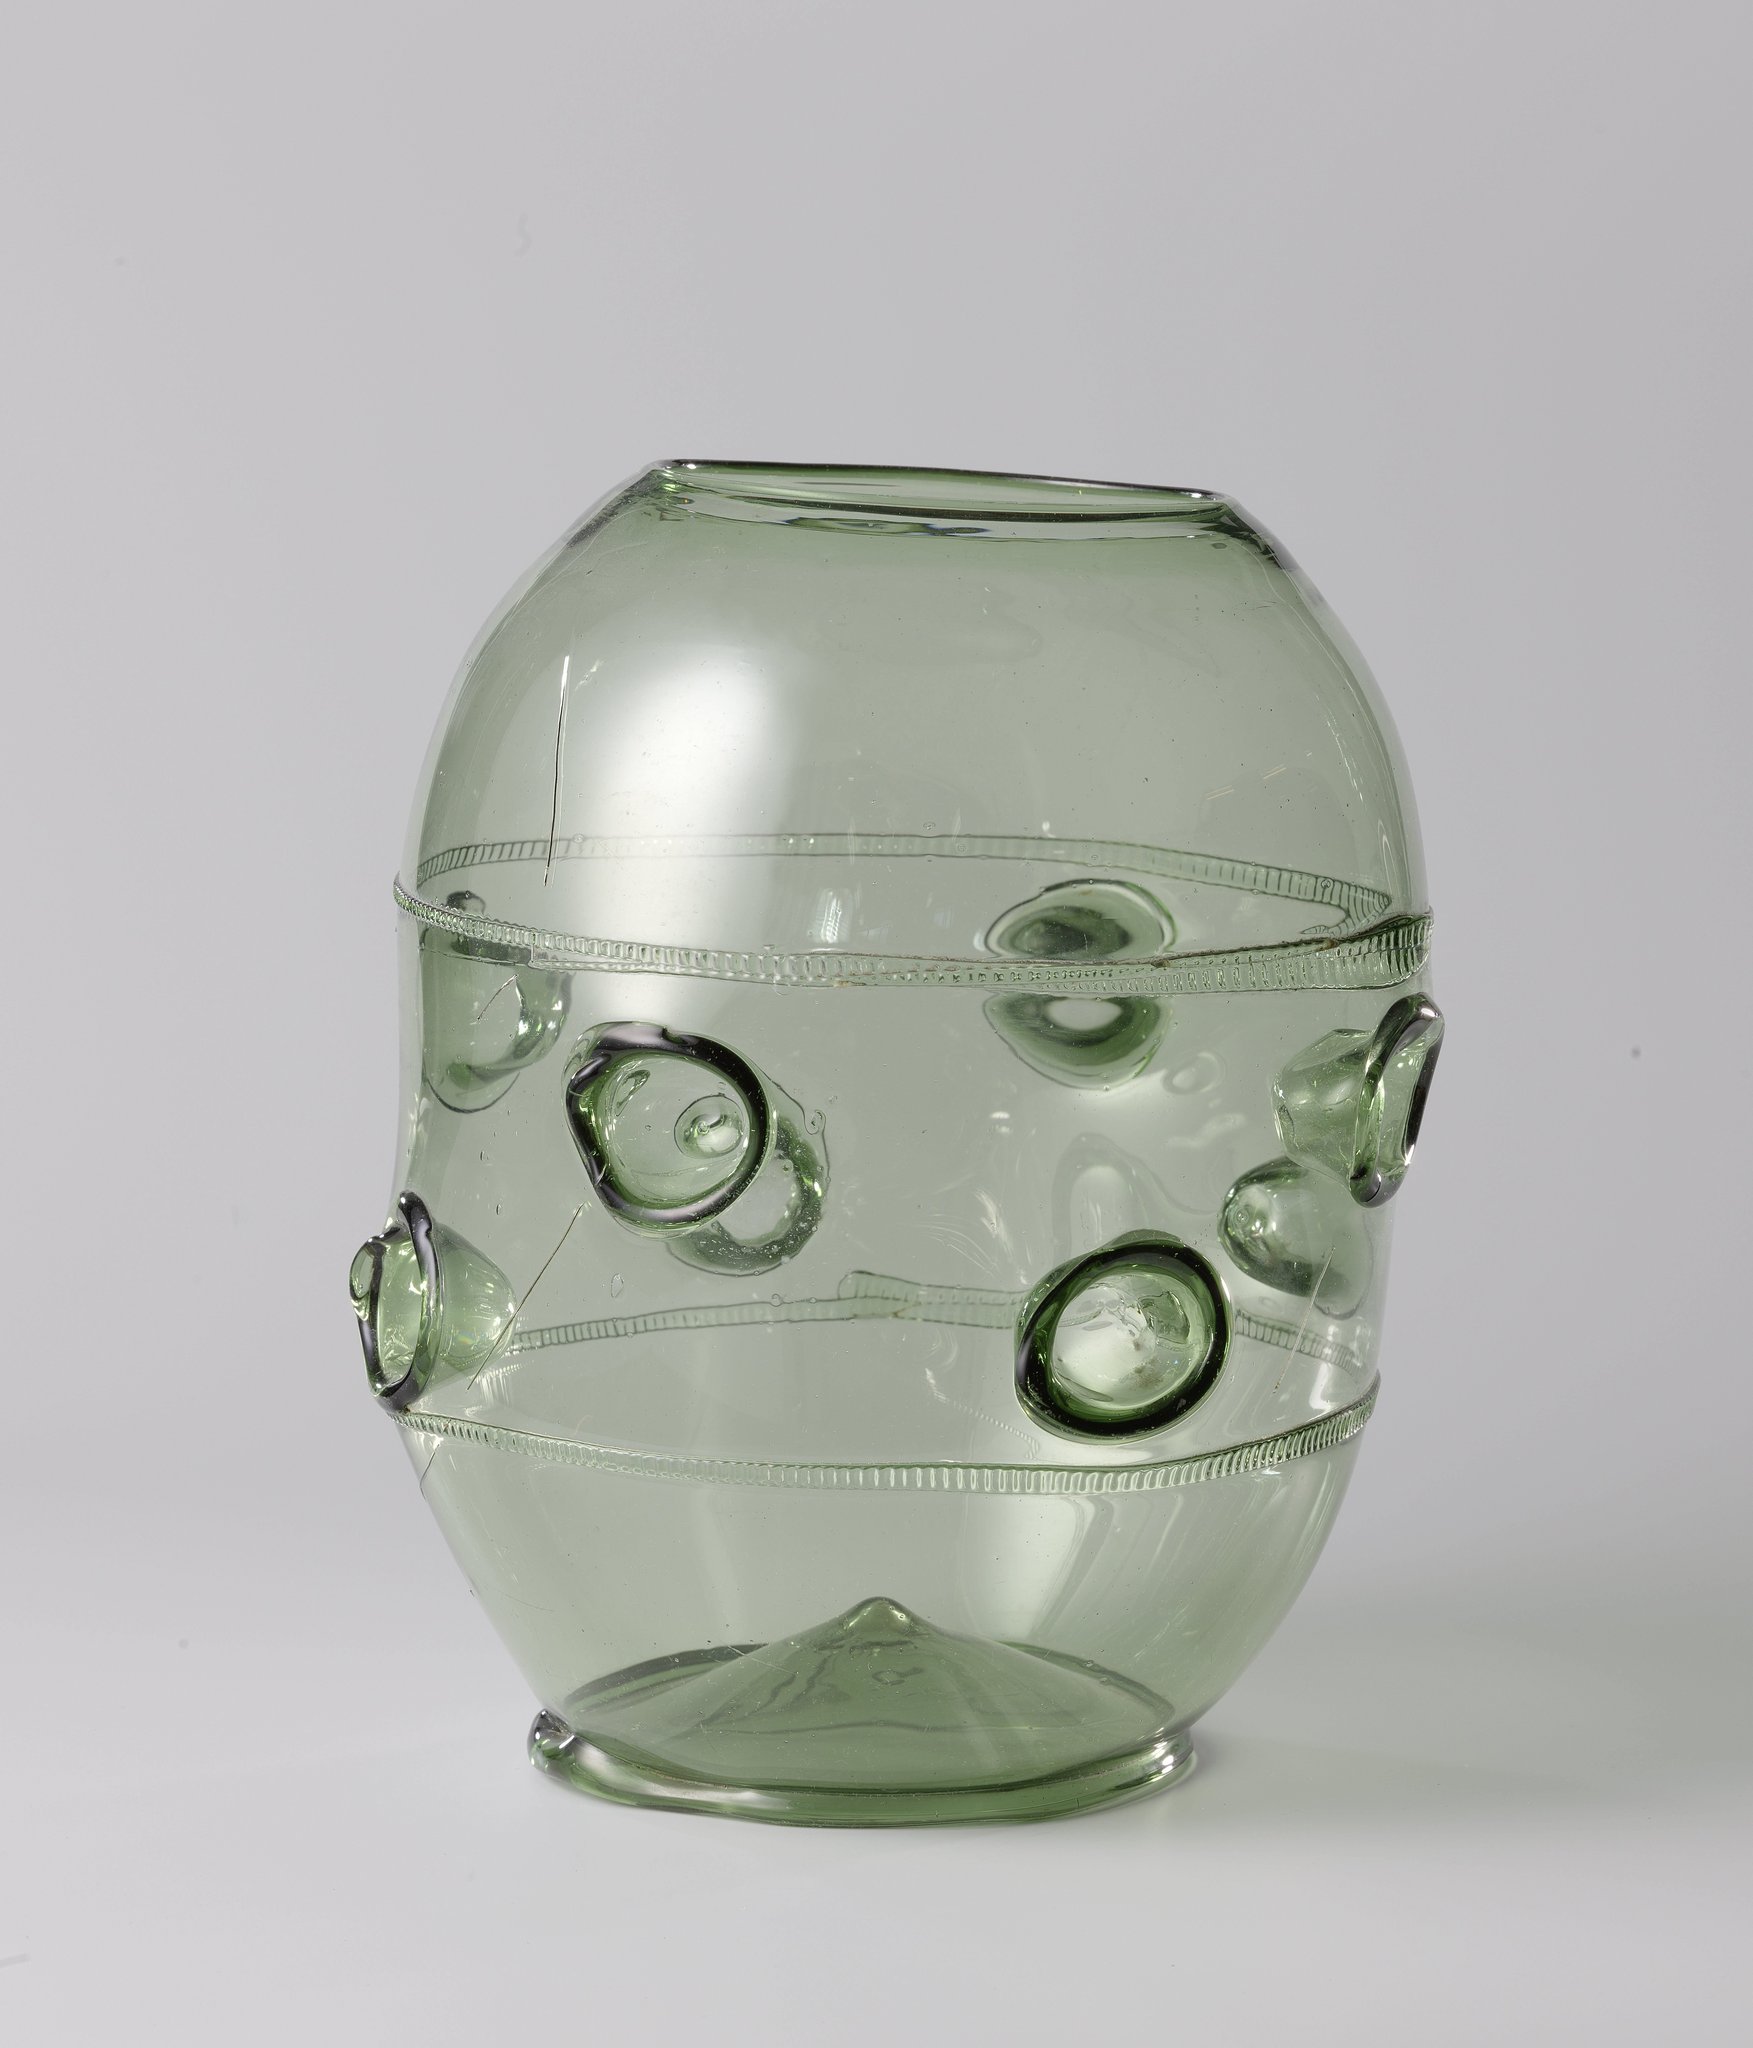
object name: duimenglas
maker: Anonymous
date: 1600-1700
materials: glass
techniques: glassblowing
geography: germany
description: Duimenglas met ingestoken bodem op gladde standring. Lichaam tonvormig met over het midden acht duimgaten tussen twee geknepen en geribde draden